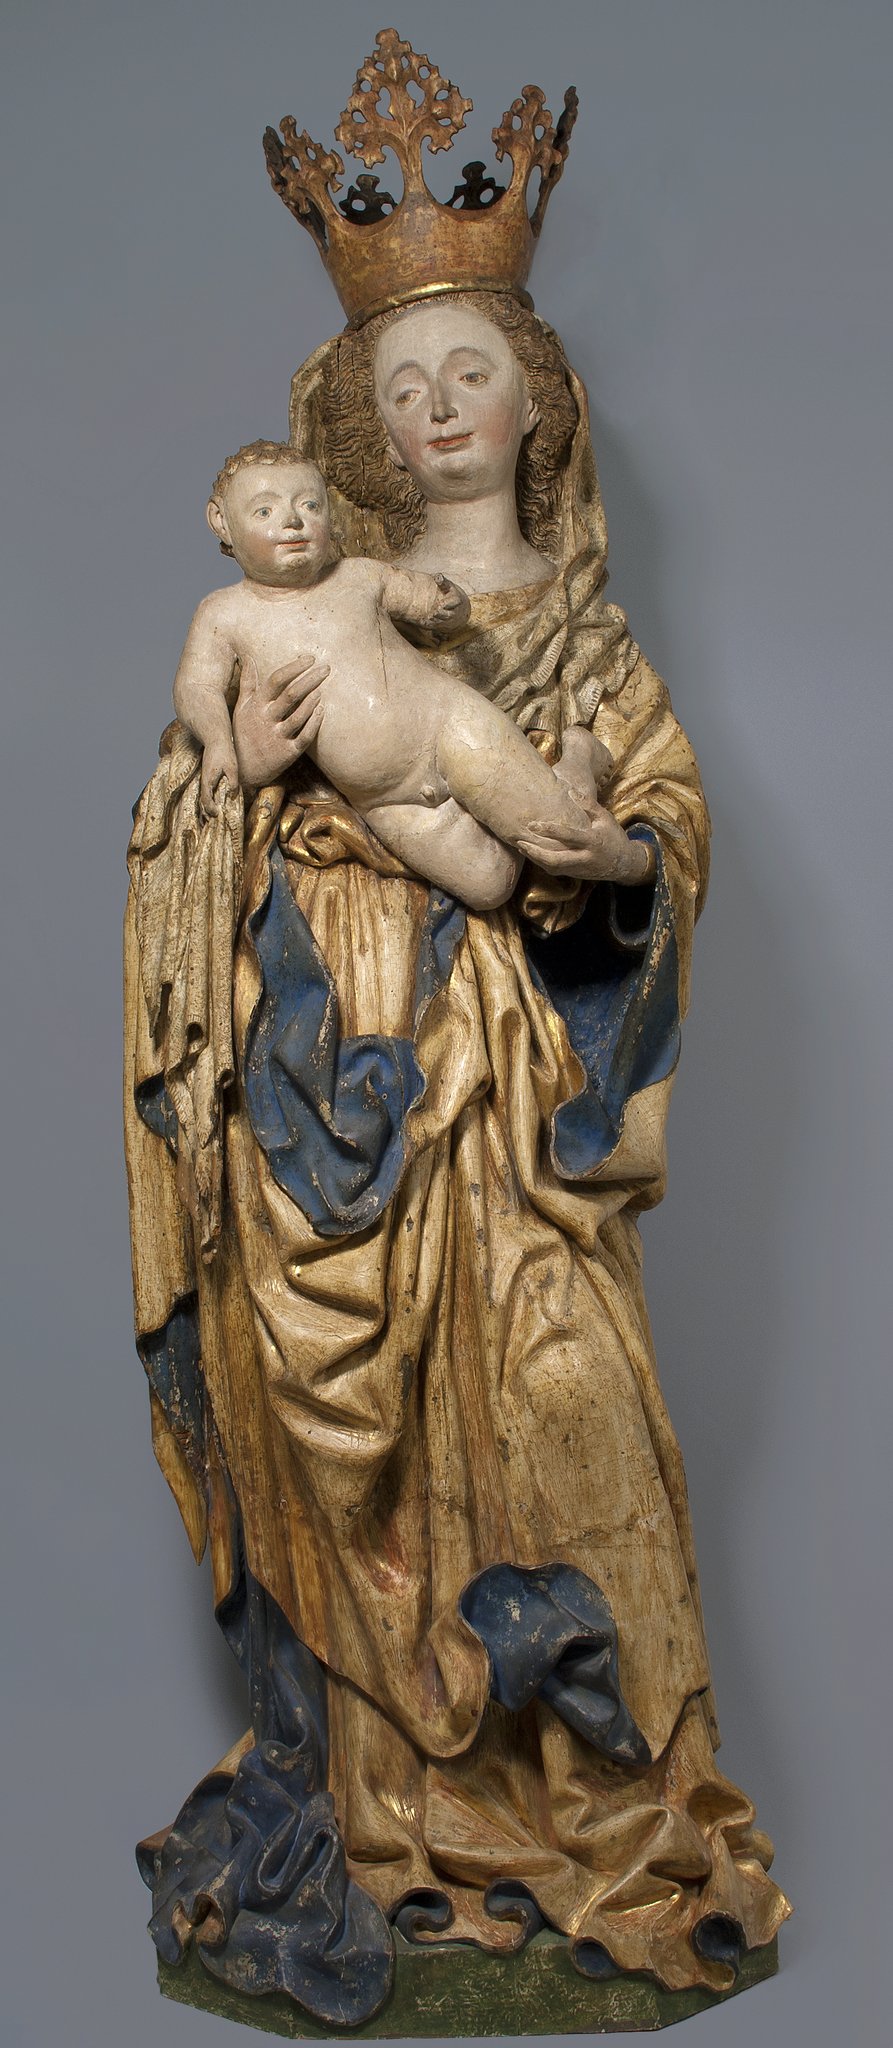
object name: statue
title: Standing Virgin and Child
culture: austrian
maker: circle of jakob kaschauer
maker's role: artist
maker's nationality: austrian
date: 1440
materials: paint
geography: austria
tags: madonna and child